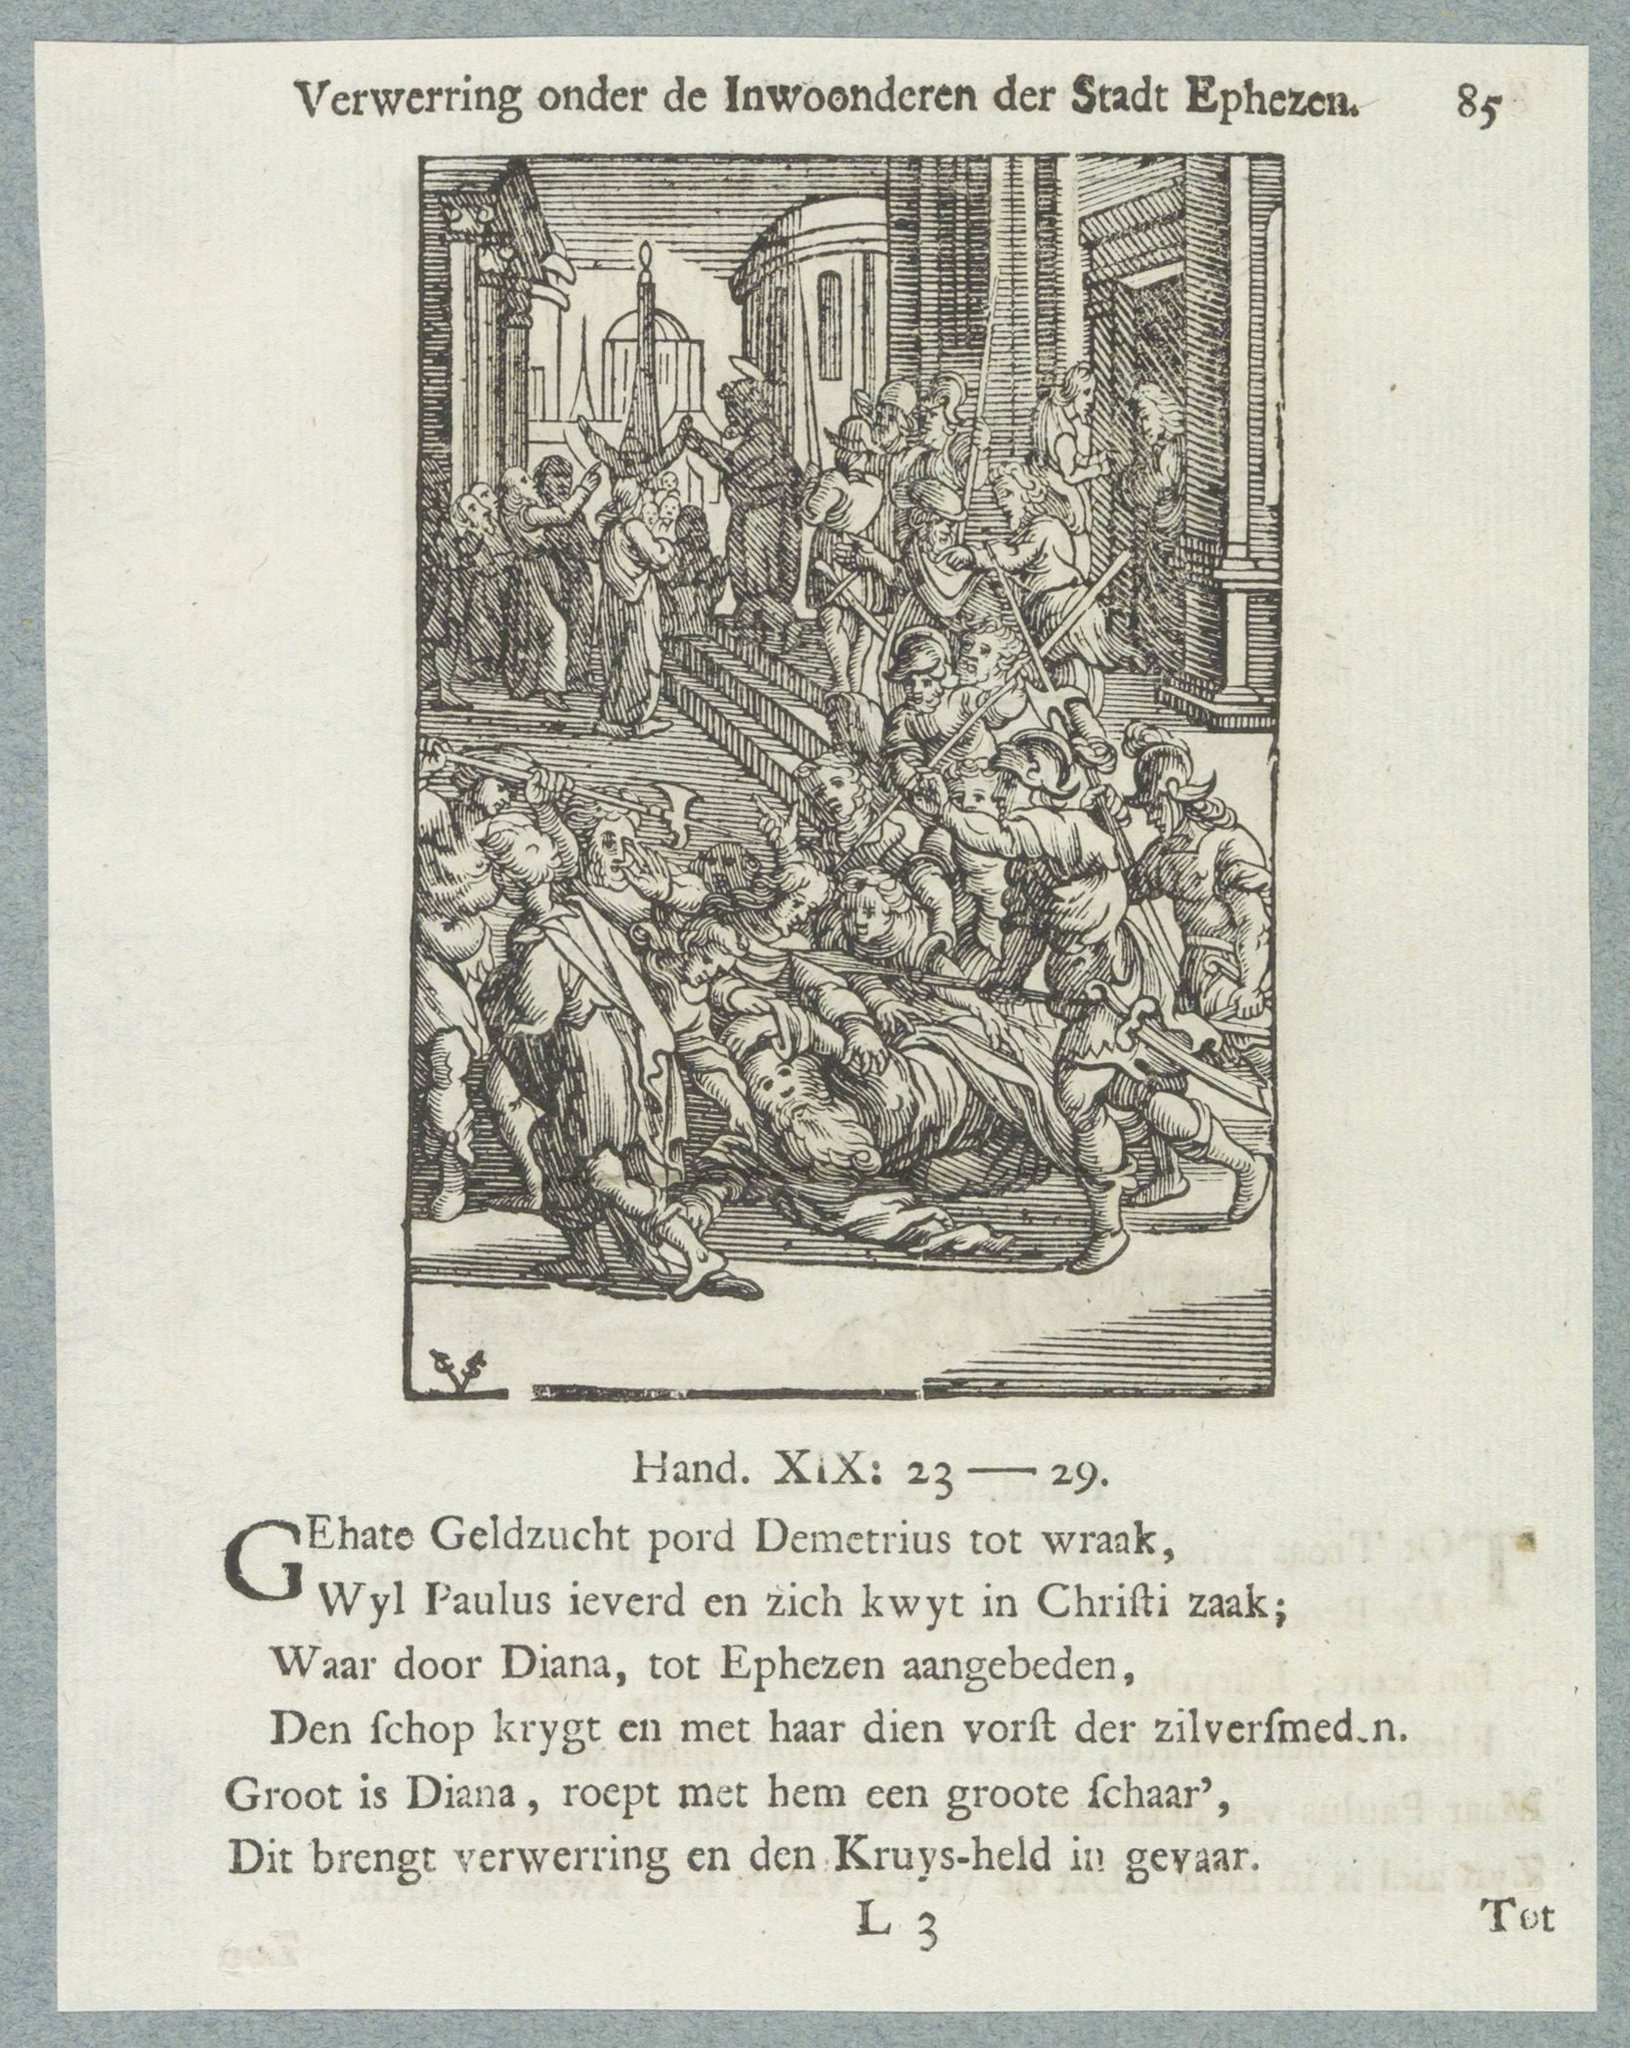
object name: book illustration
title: Verwerring onder de inwoonderen der stadt Ephezen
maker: jan klooster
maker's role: bookseller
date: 1629-1646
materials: paper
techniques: letterpress printing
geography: amsterdam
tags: the uproar in ephesus, paul speaks to the people from the stairs, paul is dragged out of the temple by the jews; he is rescued by soldiers, who arrest him and carry him away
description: Wanneer de apostel Paulus in Jeruzalem de tempel wil betreden, wordt hij door de Joden tegen de grond gesleurd en geslagen. Romeinse soldaten verwijderen de oproerkraaiers en arresteren Paulus. Op de achtergrond spreekt Paulus de Joodse menigte toe, vlak na zijn arrestatie. Hier wordt de voorstelling echter gebruikt als afbeelding van de volksoproer in Efeze waar twee Macedonische reisgenoten van Paulus het moeten ontgelden. Boven de voorstelling een titel. Eronder zes versregels en een verwijzing naar Handelingen 19: 23-29. De prent maakt deel uit van een album.